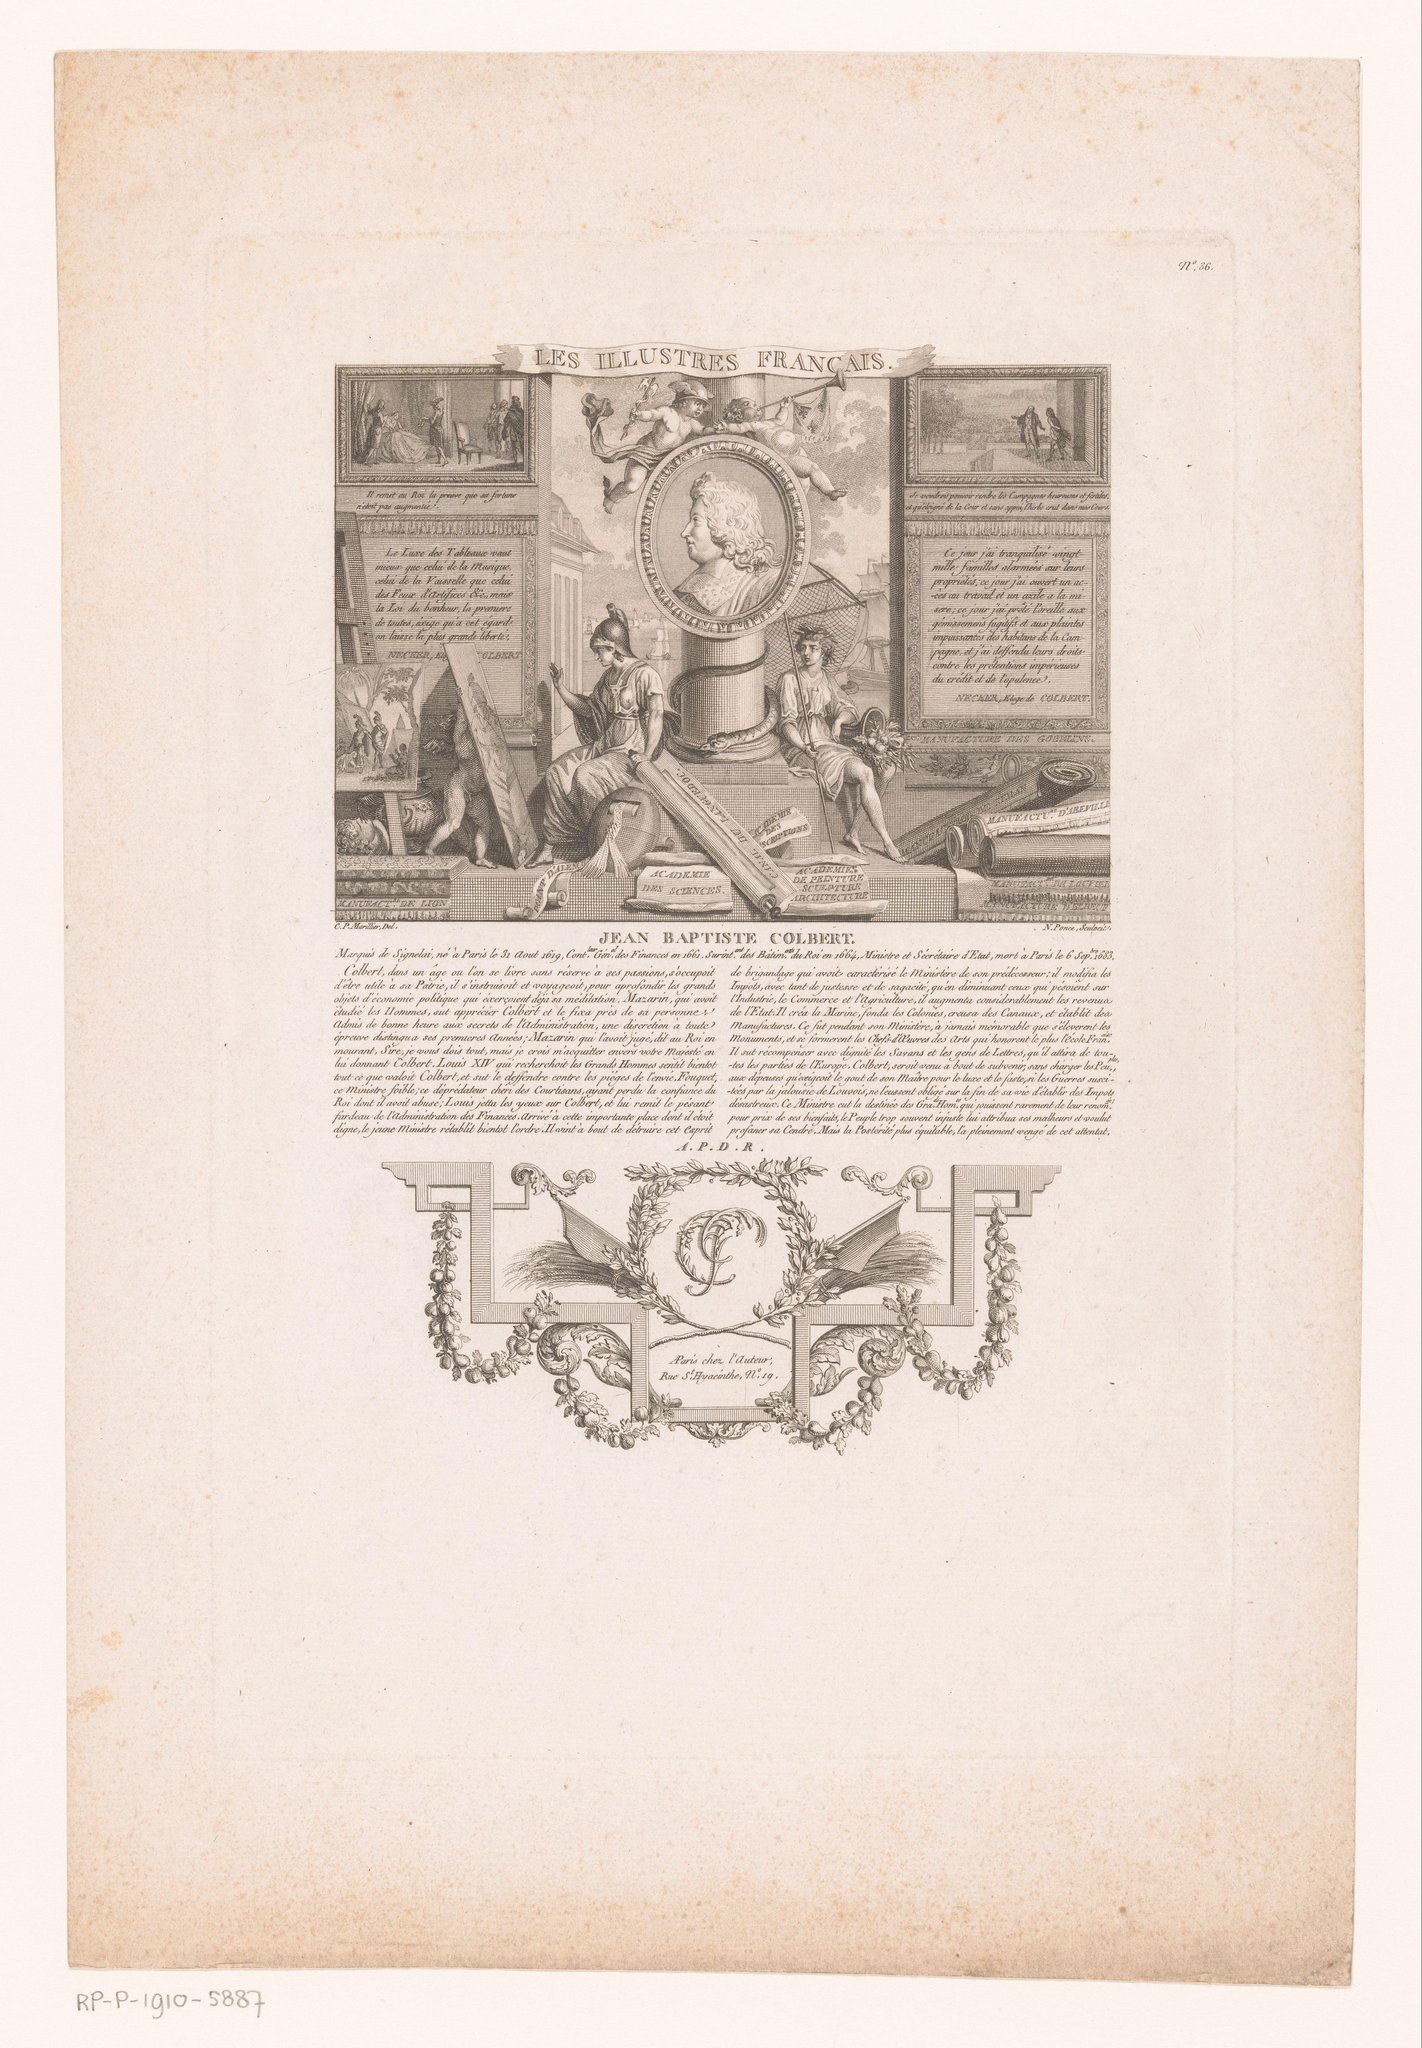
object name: print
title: Portretten van Franse historische figuren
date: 1790-1816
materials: paper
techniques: engraving, etching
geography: paris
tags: paris, politician, jean-baptiste colbert, historical persons, politician, e.g. party leader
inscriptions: collector's mark: Lugt 2228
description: Prent maakt deel uit van de serie "Les illustres français, ou tableaux historiques des grands hommes de la France pris dans tous les genres de célébrité jusqu'en 1792".